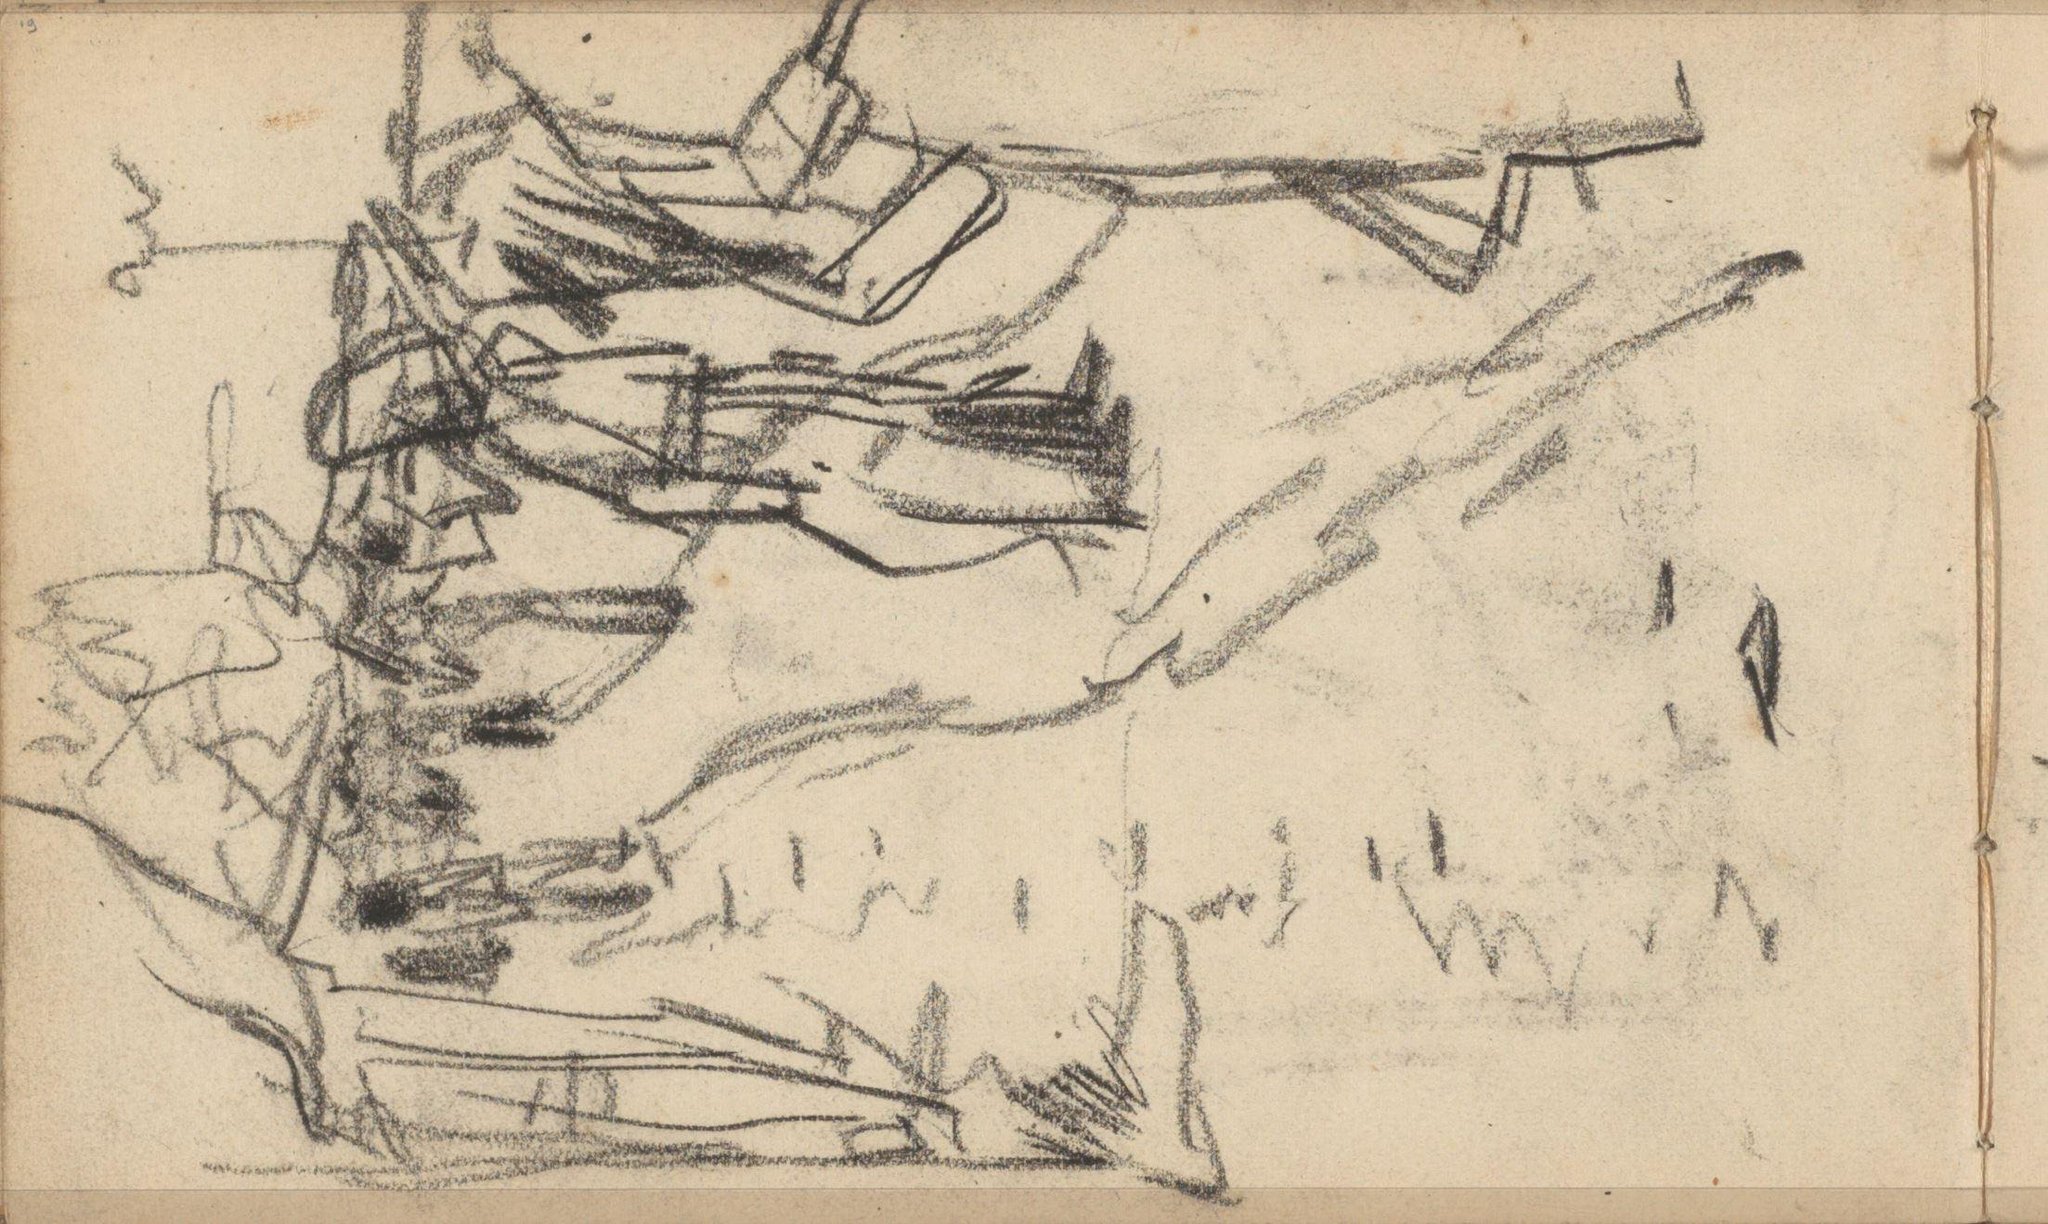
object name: sketchbook leaf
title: Soldaten met paarden op een pad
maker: george hendrik breitner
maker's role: draughtsman, painter, print maker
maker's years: 1857-1923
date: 1884-1886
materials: chalk, paper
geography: the hague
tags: land forces (+ artillery), road, path, horse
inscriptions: kleurnotitie, handgeschreven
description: Mogelijk artilleristen. Pagina 19 uit een schetsboek met 35 bladen.